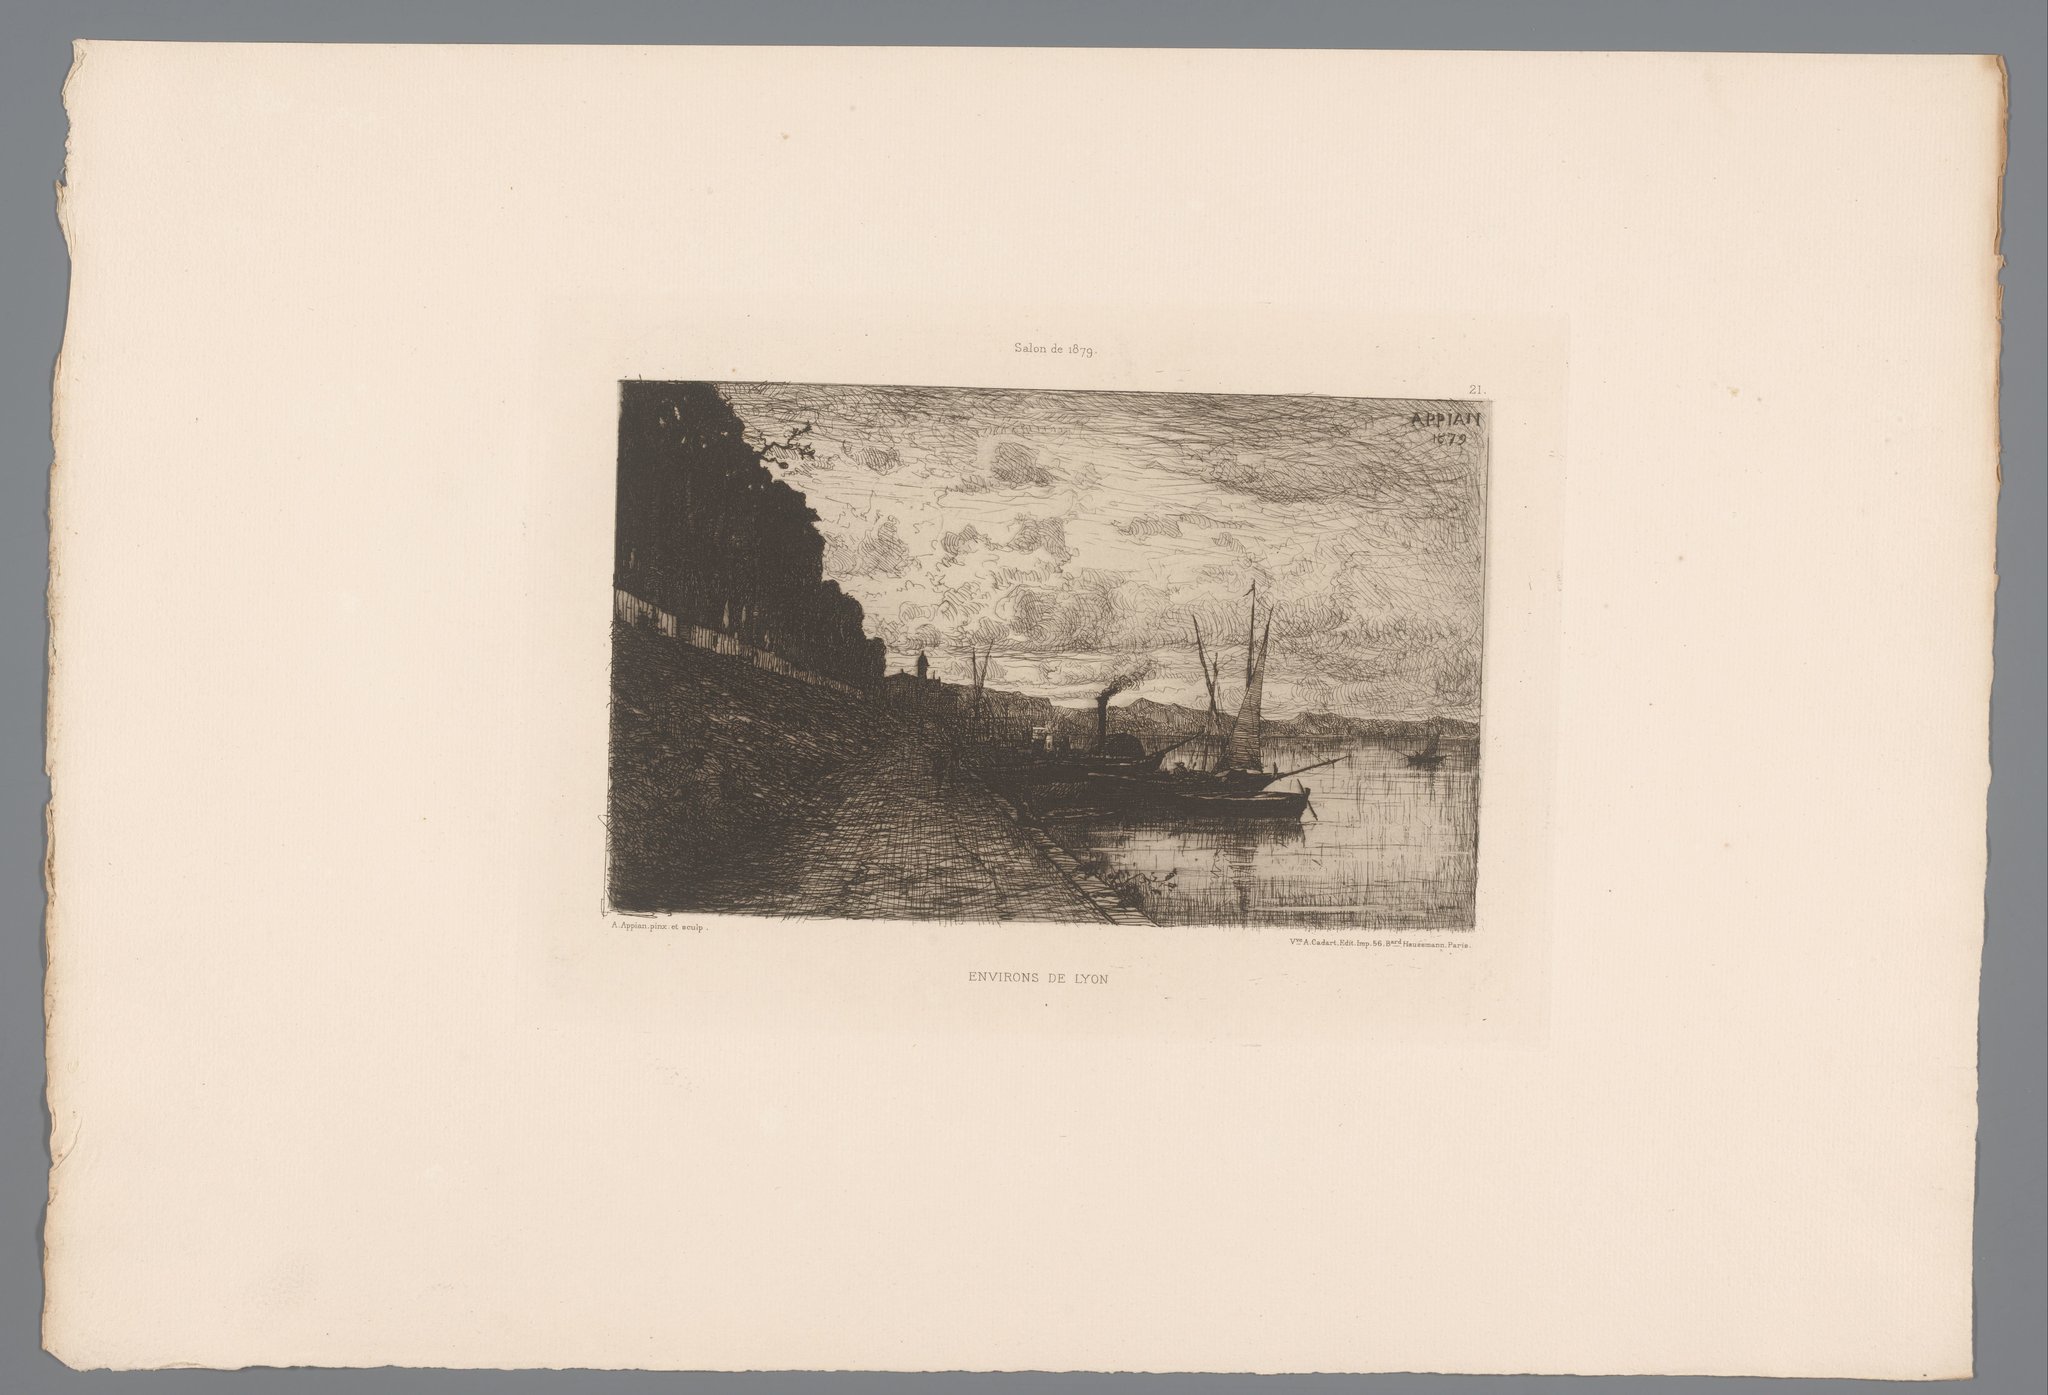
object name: print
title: L'eau-forte en 1880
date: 1880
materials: paper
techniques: drypoint, etching, intaglio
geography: paris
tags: canals, waters (in city), lyon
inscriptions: collector's mark: Lugt 2760, collector's mark: Lugt 2228, collector's mark: ‘AFE v S’, watermark